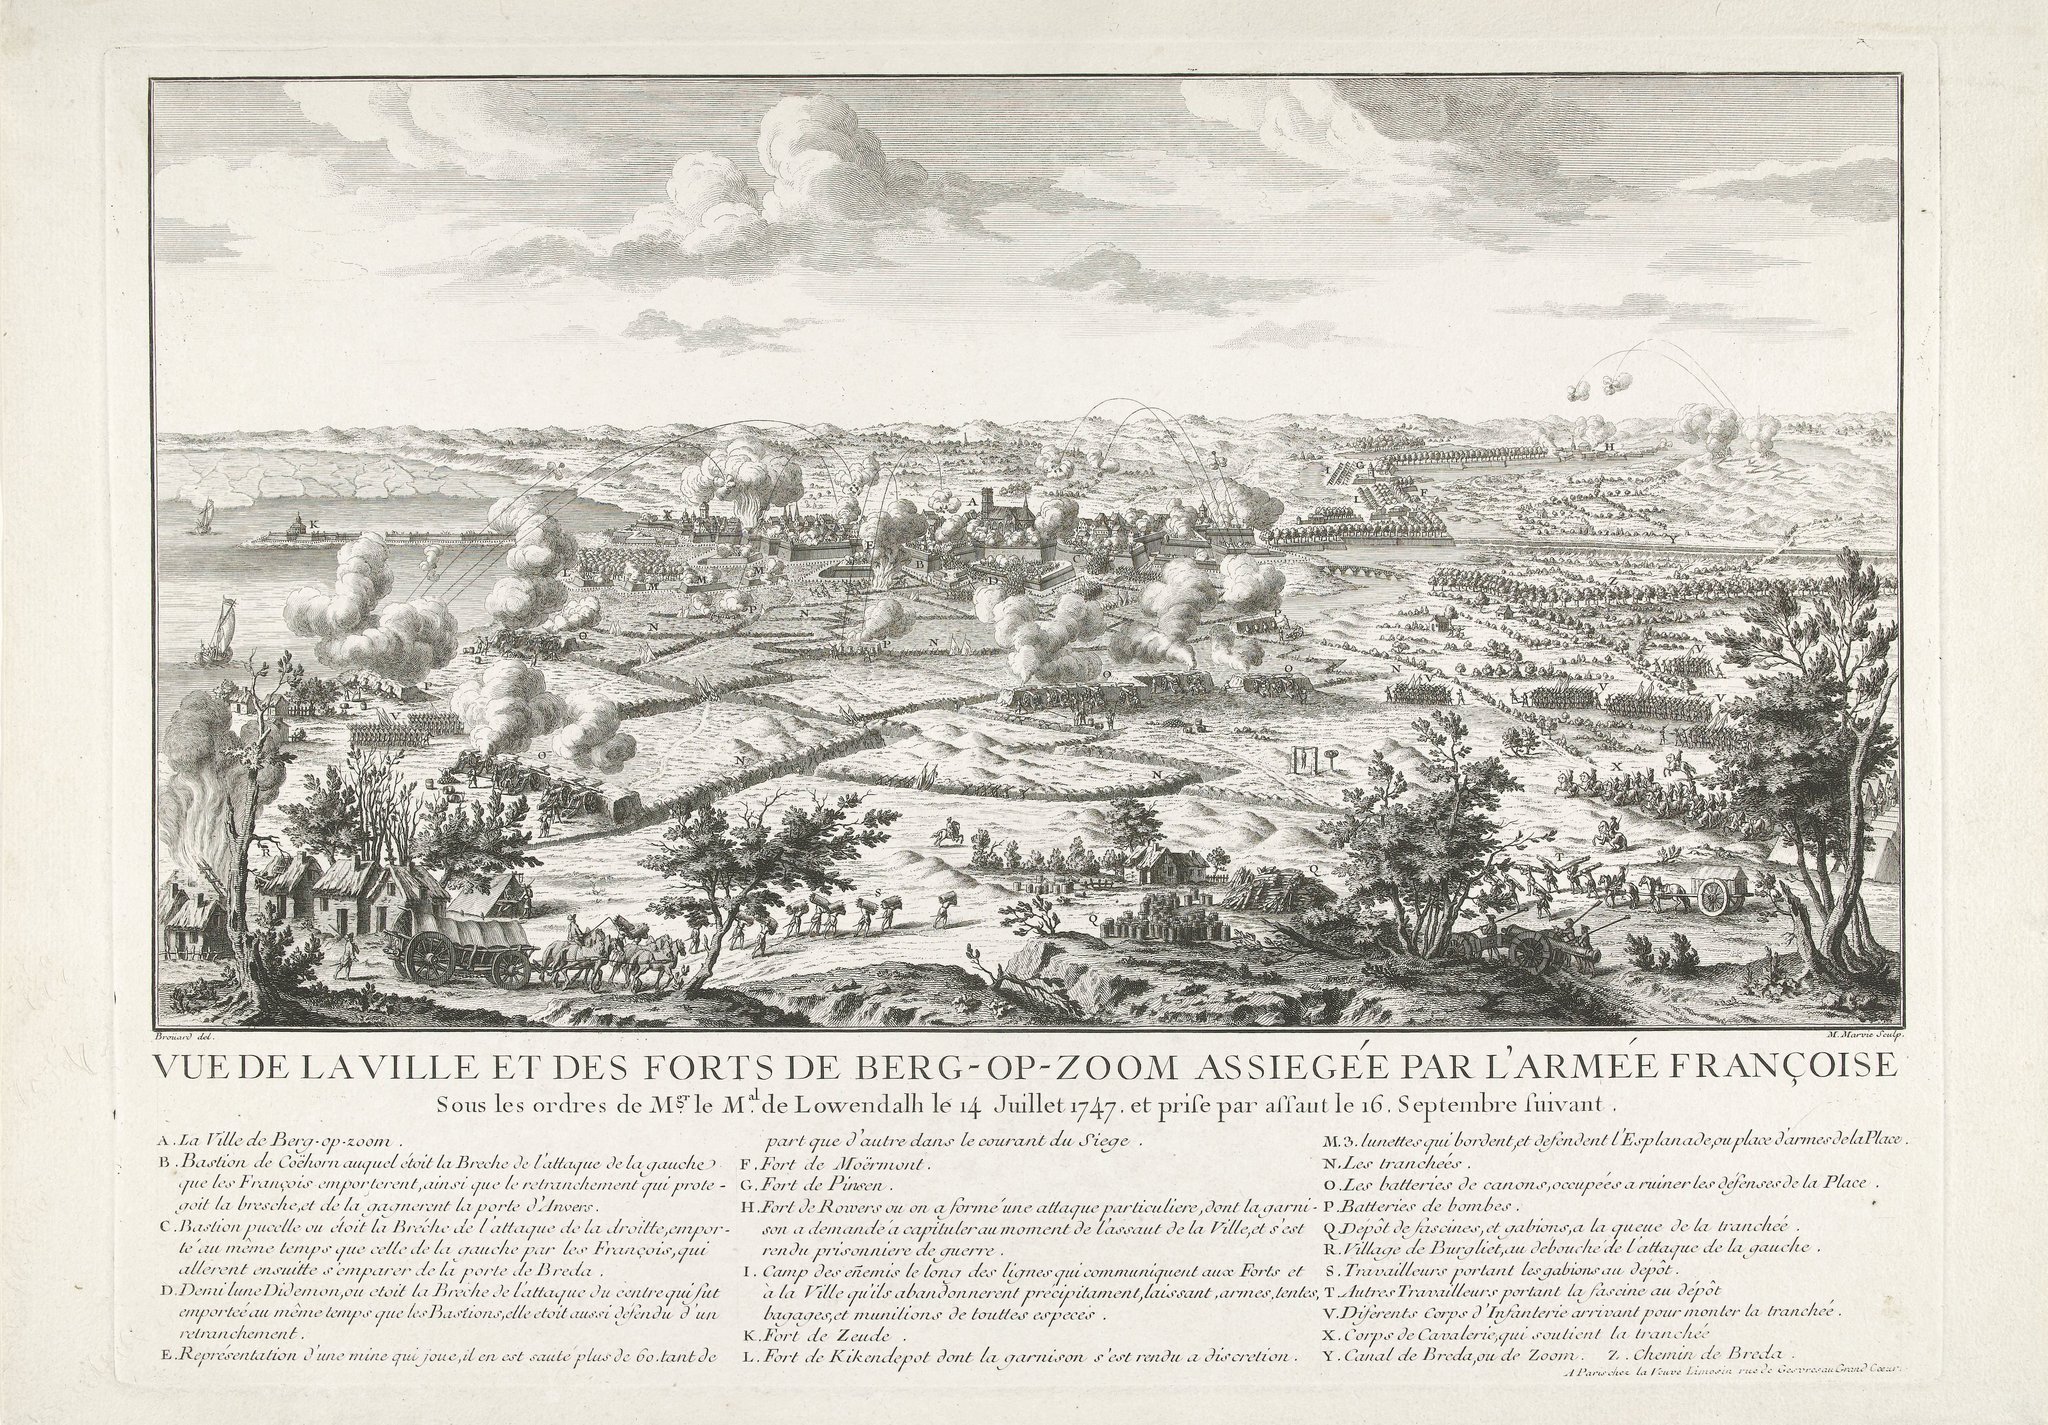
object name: print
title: Vue de la ville et des forts de Berg-op-Zoom assiegée par l'armée Françoise sous les ordres de Mgr. le Mal. de Lowendalh le 14 Juillet 1747. et prise par assaut le 16. Septembre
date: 1747-1750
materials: paper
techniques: etching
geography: france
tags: siege, position war, bergen op zoom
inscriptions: collector's mark: Lugt 2233, collector's mark: Lugt 2228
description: Gezicht op het beleg en bombardement van de stad Bergen op Zoom door het Franse leger onder Löwenthal. In het onderschrift de legenda A-Y in het Frans.